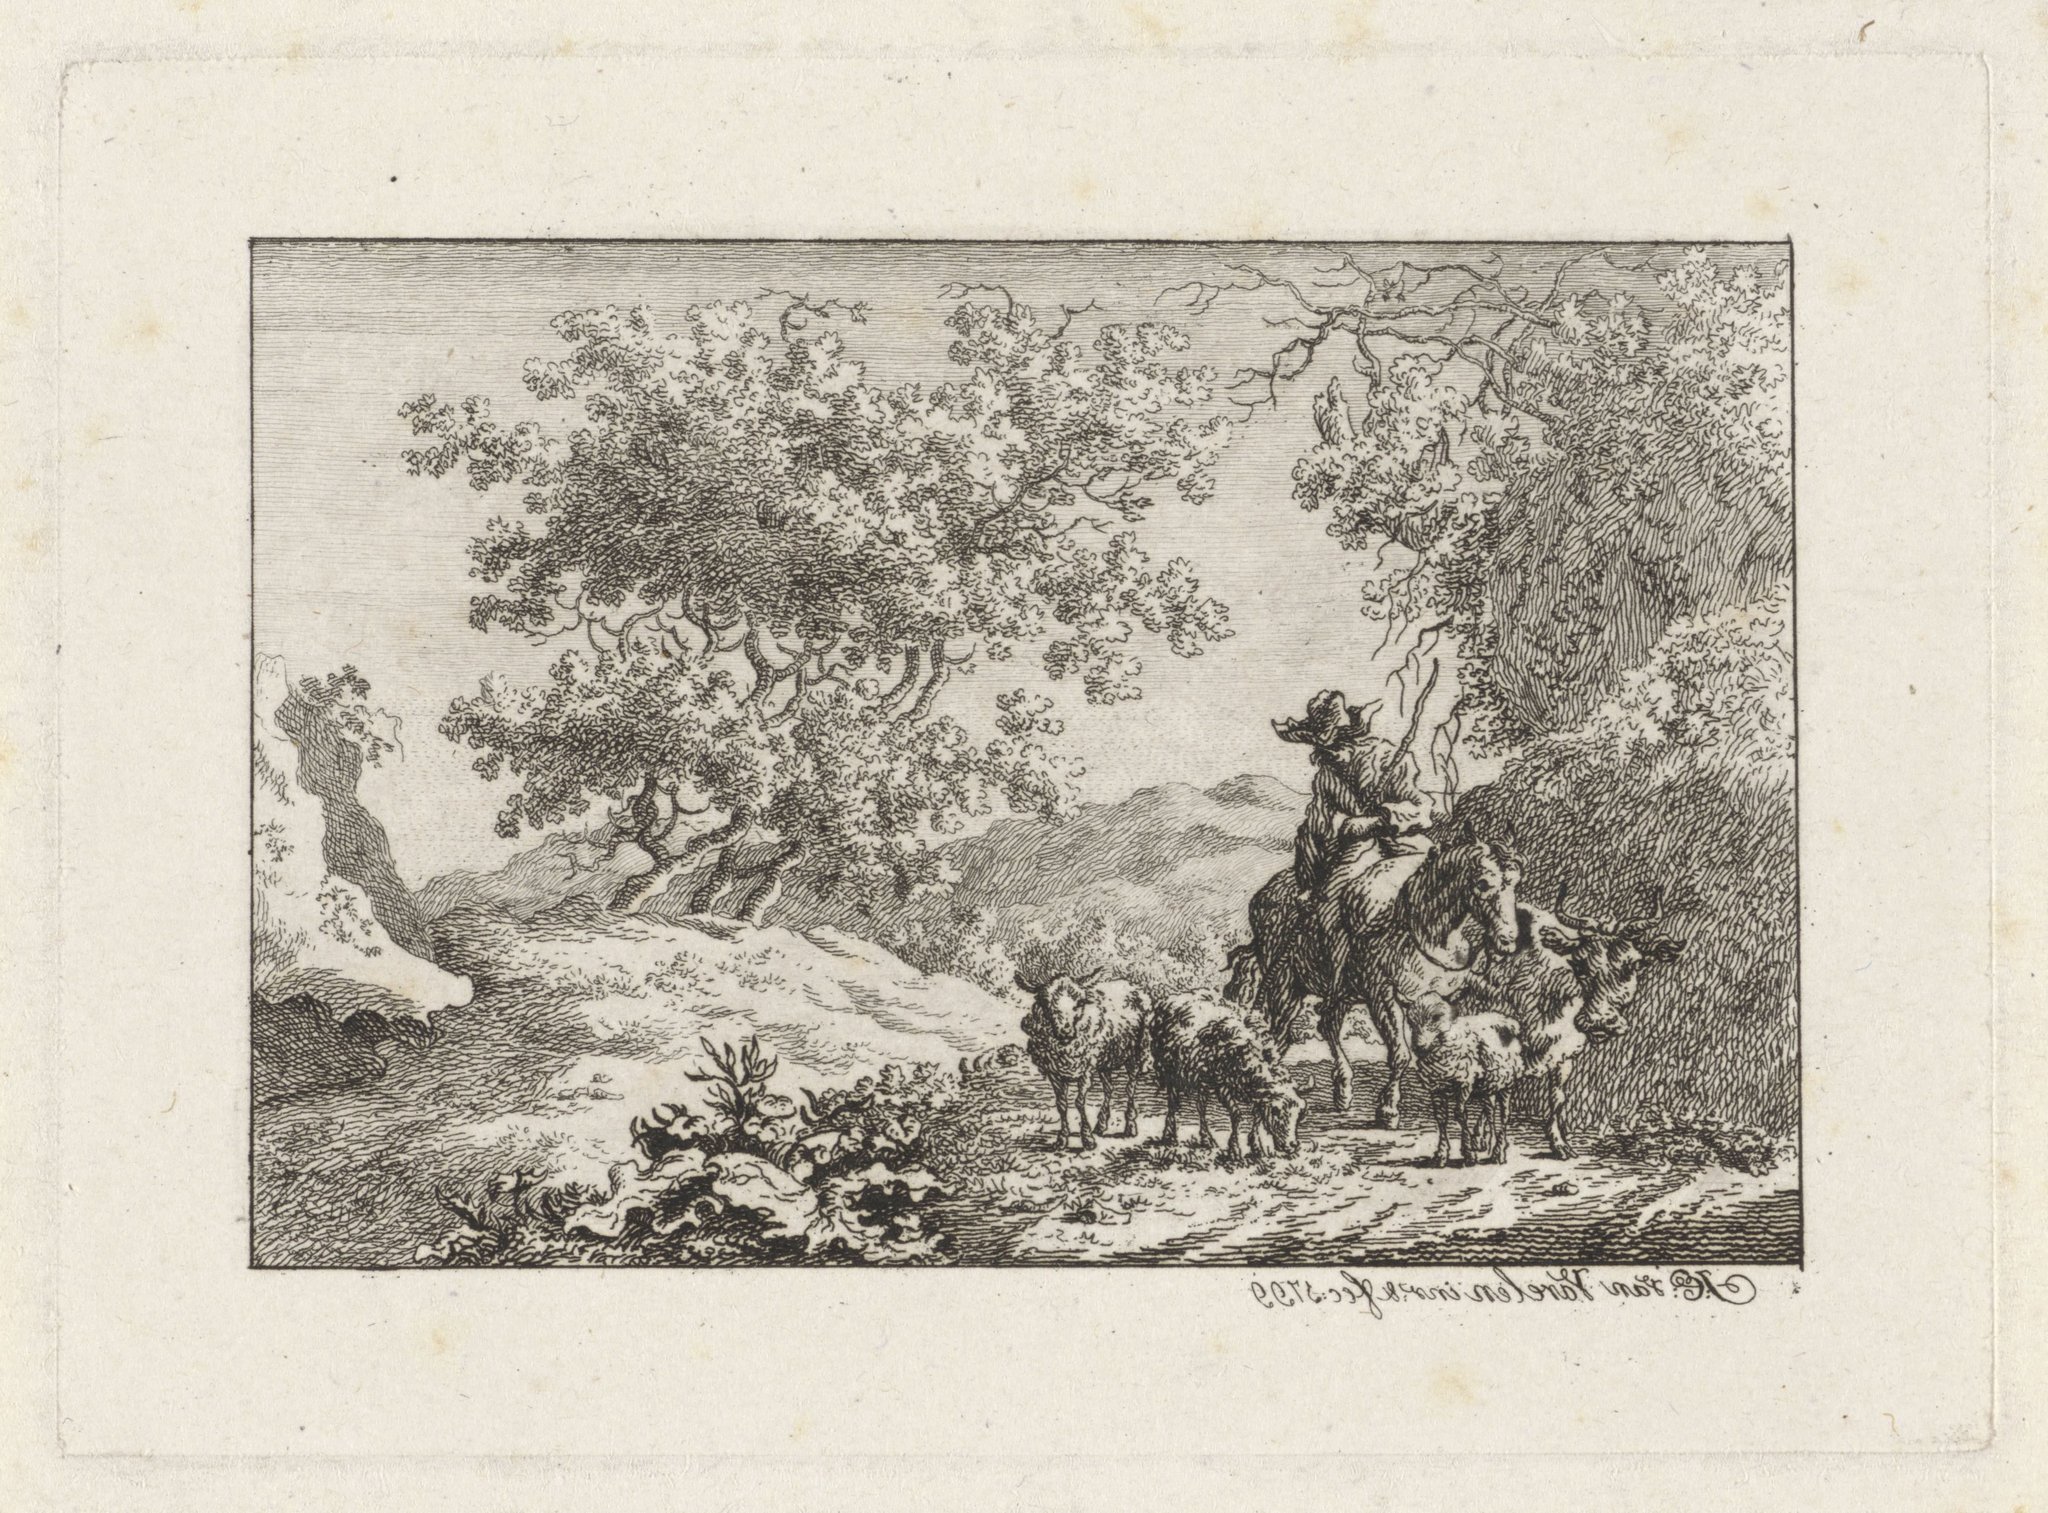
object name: print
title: Herder te paard met kudde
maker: jacob elias van varelen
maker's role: draughtsman, print maker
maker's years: 1757-1840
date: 1799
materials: paper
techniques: etching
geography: haarlem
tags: riding a horse, ass, or mule; rider, horseman, cow, cattle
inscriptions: collector's mark: Lugt 2228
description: Herder te paard met zijn kudde in een heuvelachtig landschap.